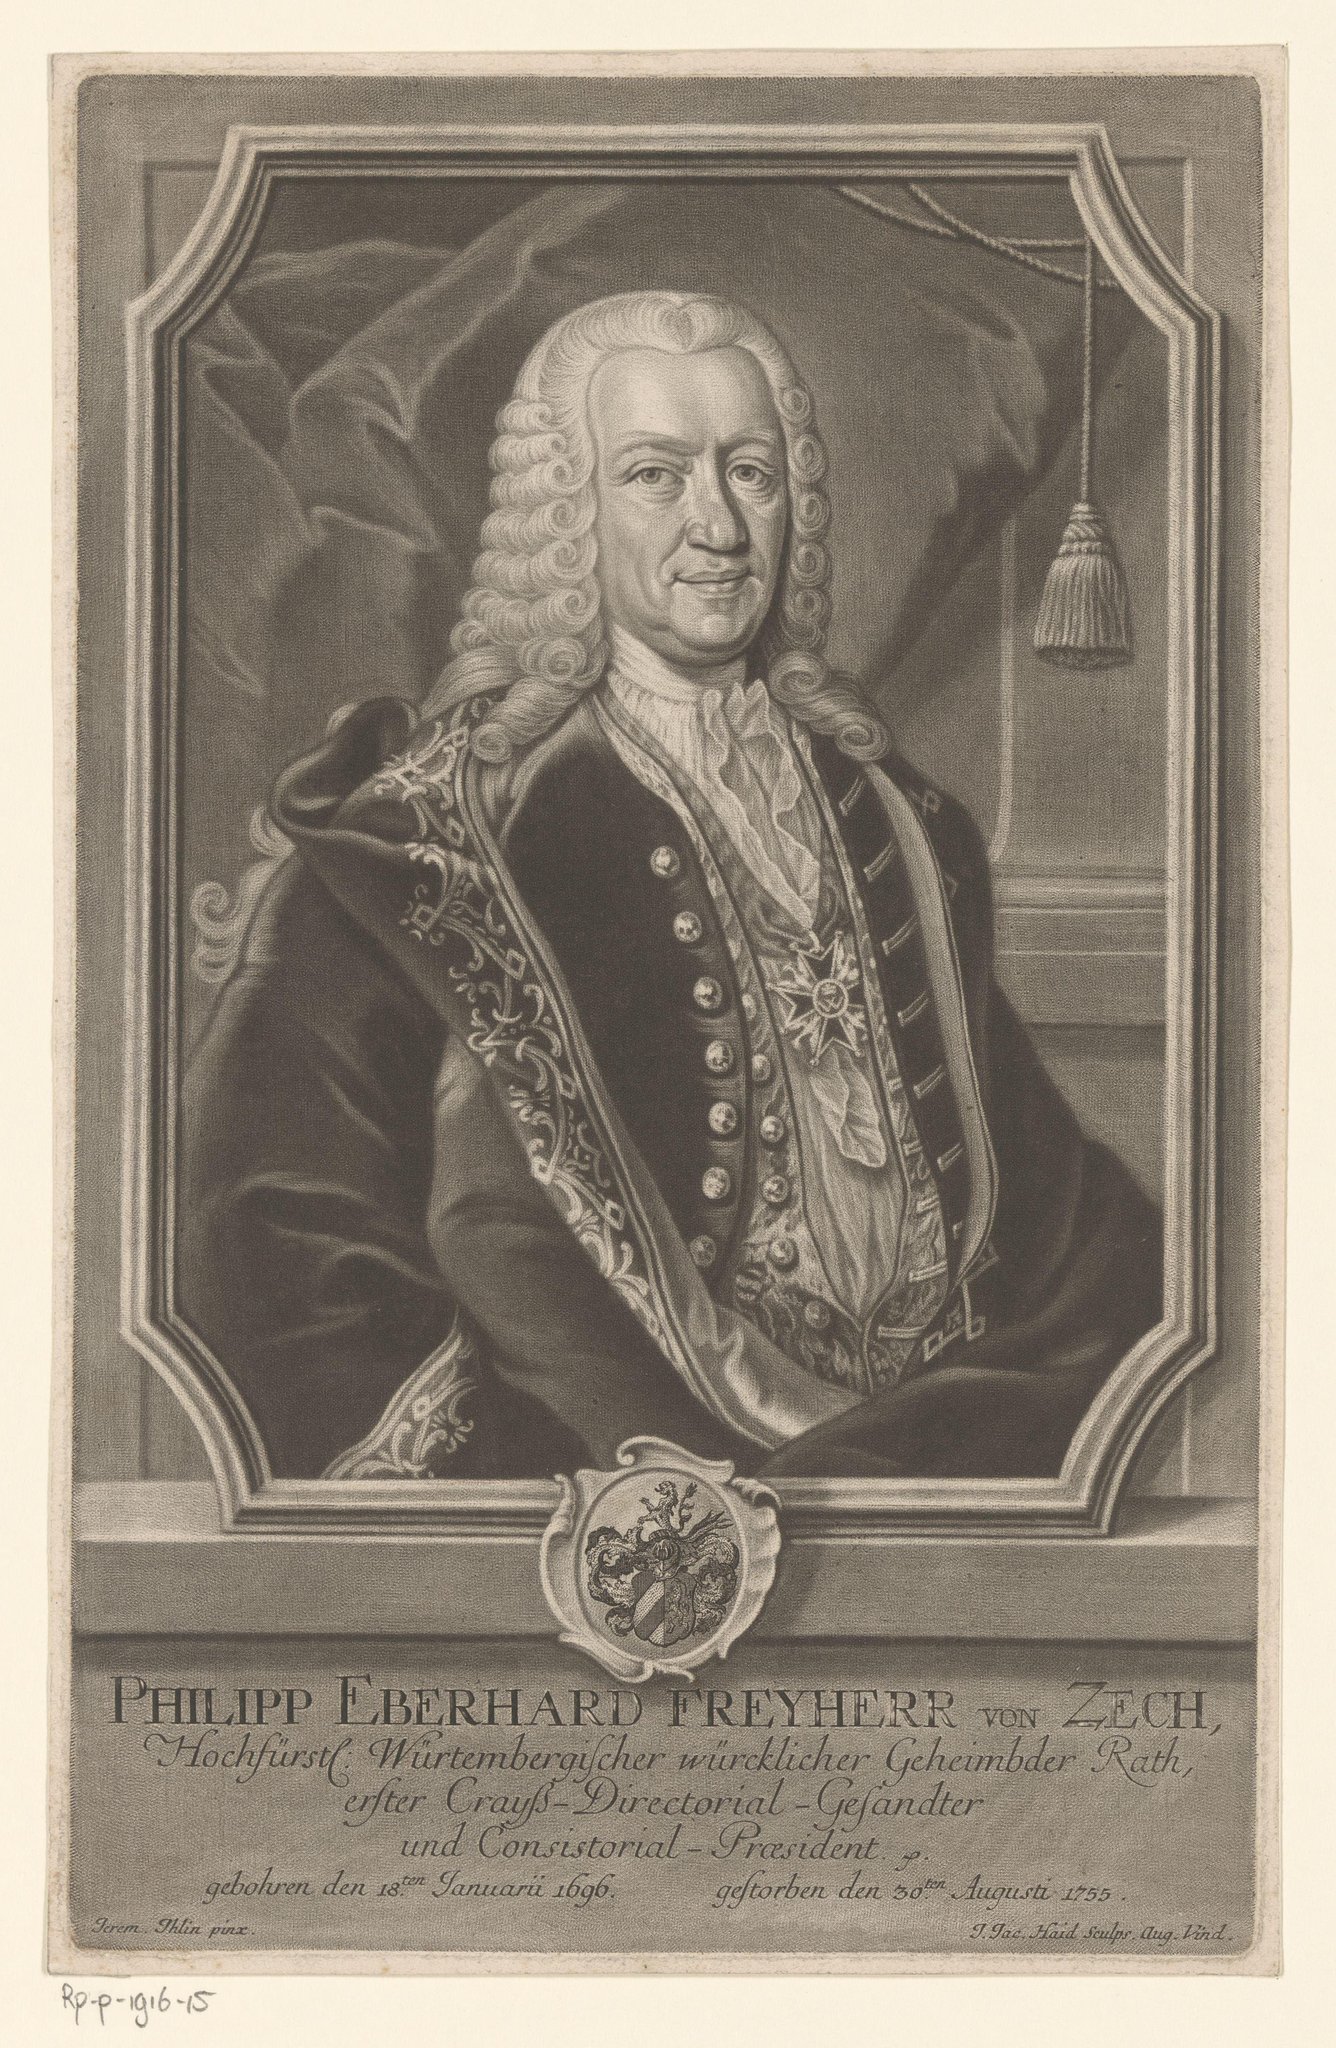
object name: print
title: Portret van Philipp Eberhard Zech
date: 1755-1767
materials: paper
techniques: etching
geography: augsburg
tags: historical persons, armorial bearing, heraldry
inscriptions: collector's mark: Lugt 2228